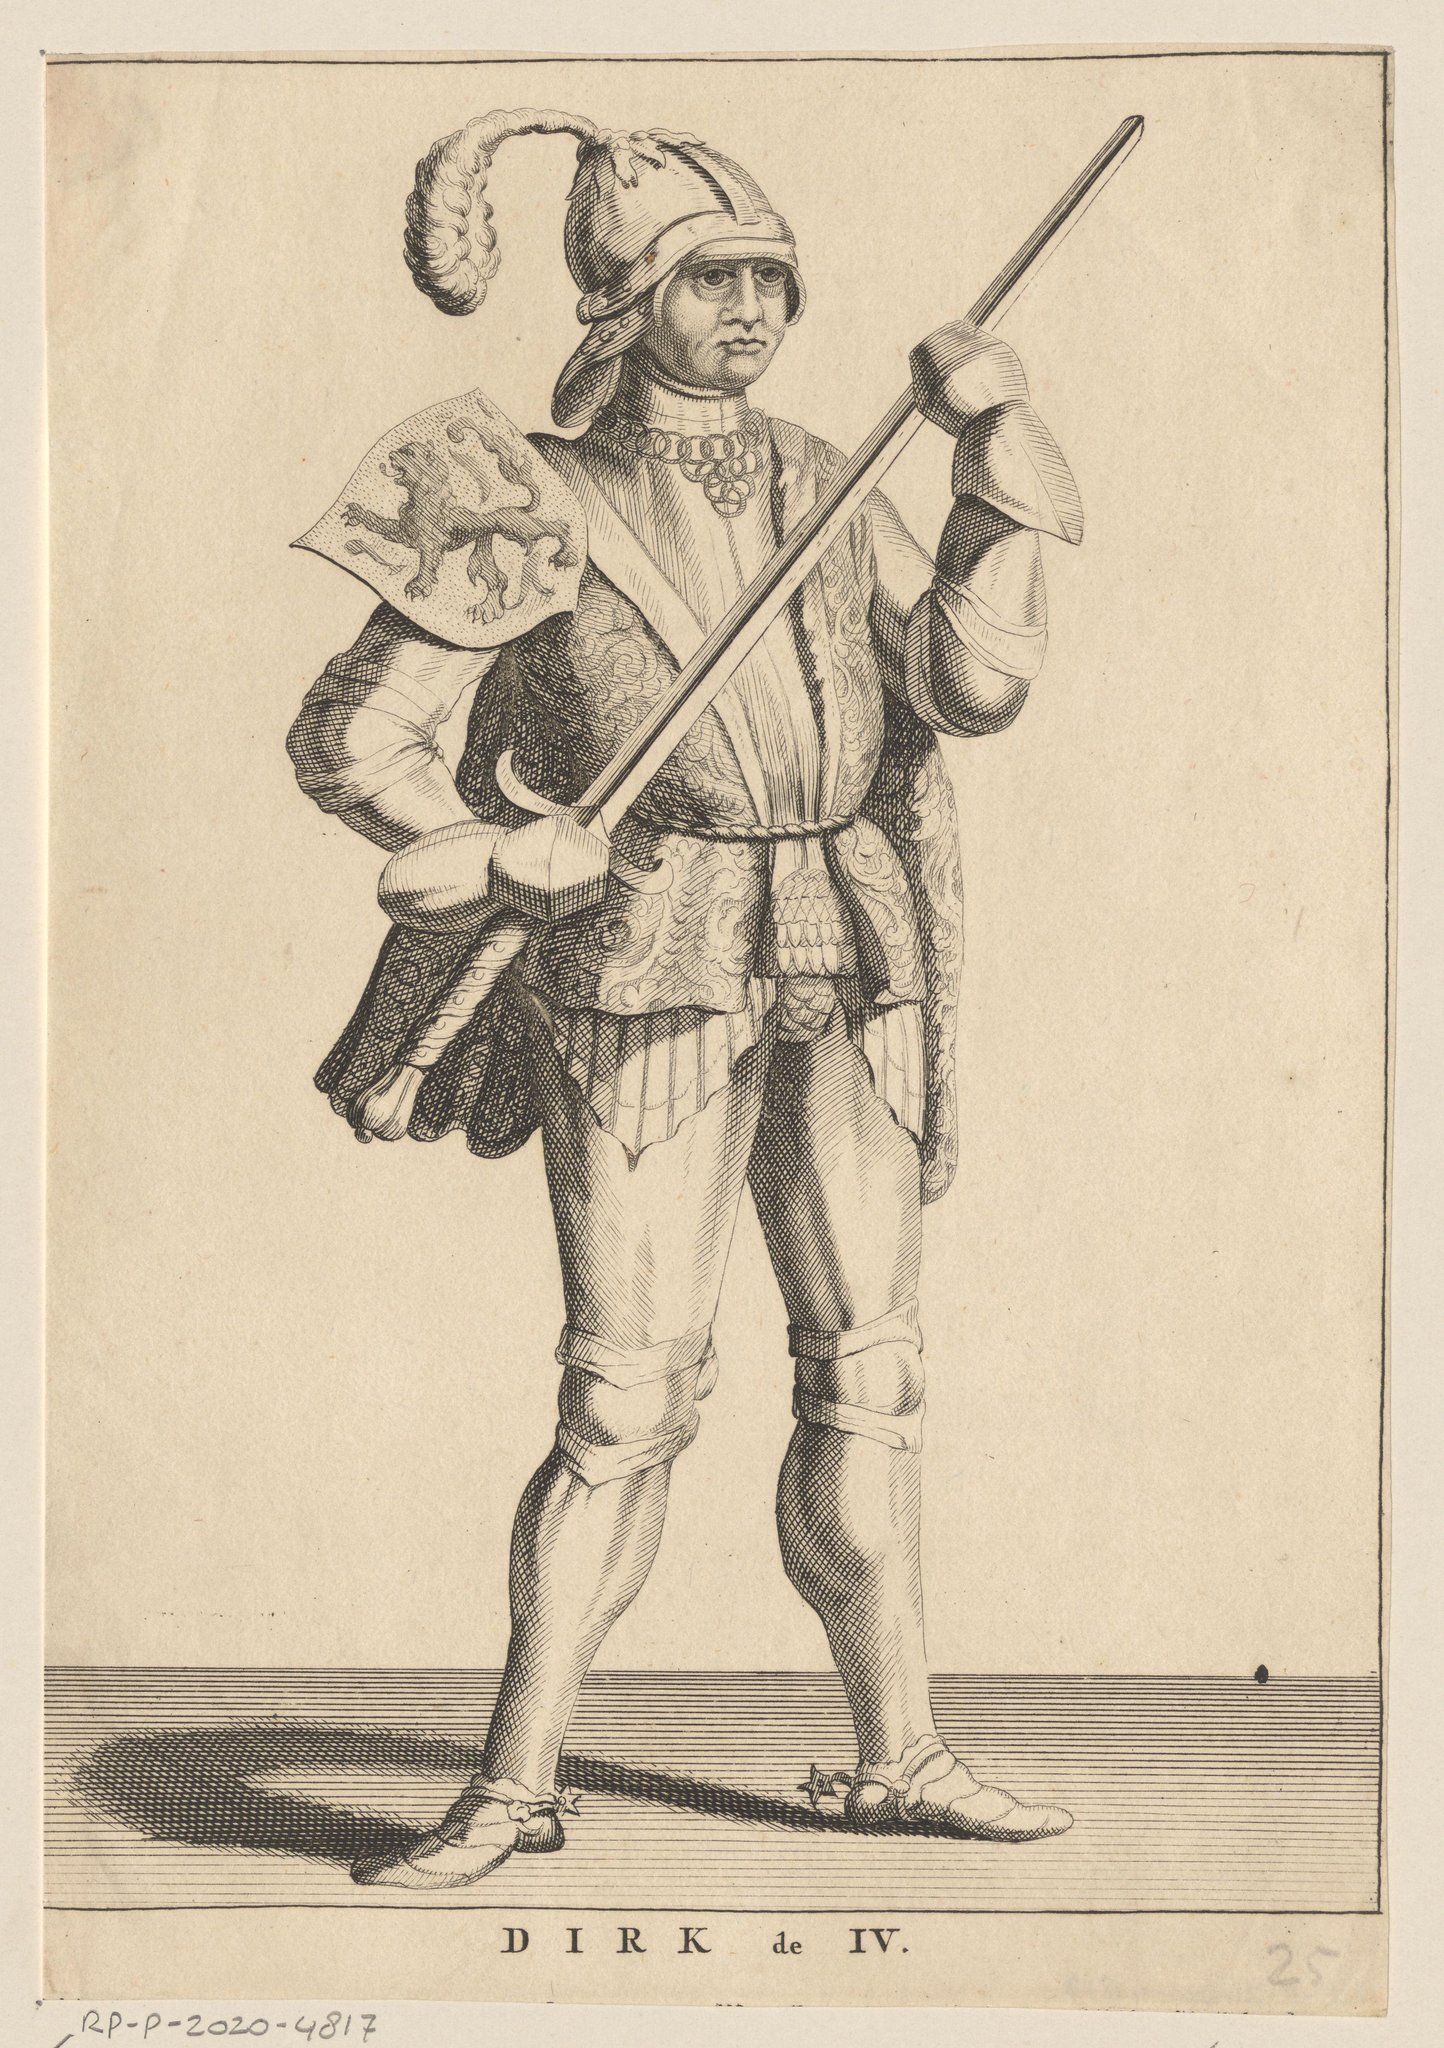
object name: print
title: Portret van Dirk IV, graaf van Holland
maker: Anonymous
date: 1699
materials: paper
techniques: engraving, etching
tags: dordrecht, historical persons, hacking and thrusting weapons: sword, ruler, sovereign, armorial bearing, heraldry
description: Prent waarschijnlijk uit: Stoke, Melis. Hollandse jaar-boeken of rijm-kronijk van Melis Stoke. Behelsende de geschiedenissen des lands (...). Leiden: Johannes du Vivié en Isaak Severinus, 1699. Latere staat van prent gebruikt in: Halma, François. Tooneel der Vereenigde Nederlanden, en onderhorige landschappen (...). 2 dln. Leeuwarden: Hendrik Halma, 1725, dl. 1, fol. 279.